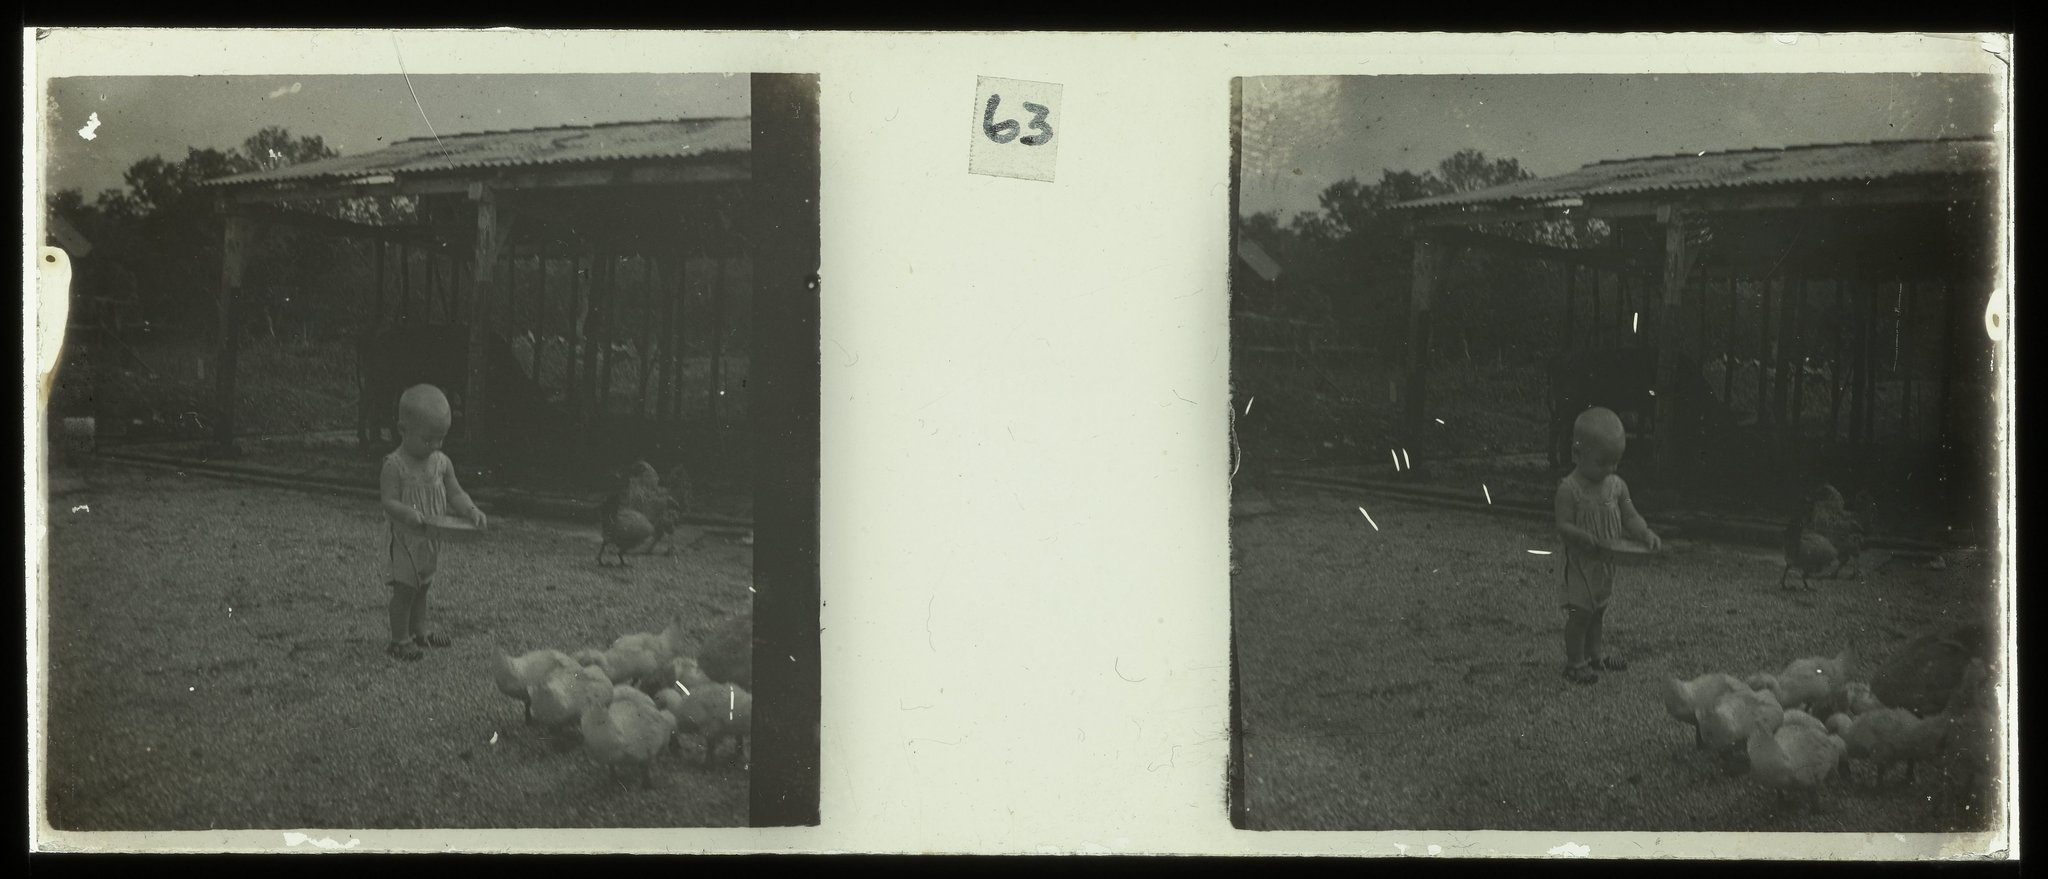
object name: stereograph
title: Plantage Accaribo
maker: theodoor brouwers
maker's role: amateurfotograaf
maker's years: 1874-1932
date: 1913-1930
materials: glass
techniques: photography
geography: suriname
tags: theodoor brouwers, plantation, suriname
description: In de periode 1911-1932 woonde op plantage Accaribo in Suriname de familie Brouwers van wie de foto's afkomstig zijn. Rond 1910 vond Theodoor Brouwers werk op plantage Accaribo. In 1929 werd hij eigenaar van de plantage. Op Accaribo werden in zijn tijd bananen geproduceerd en wat koffie.